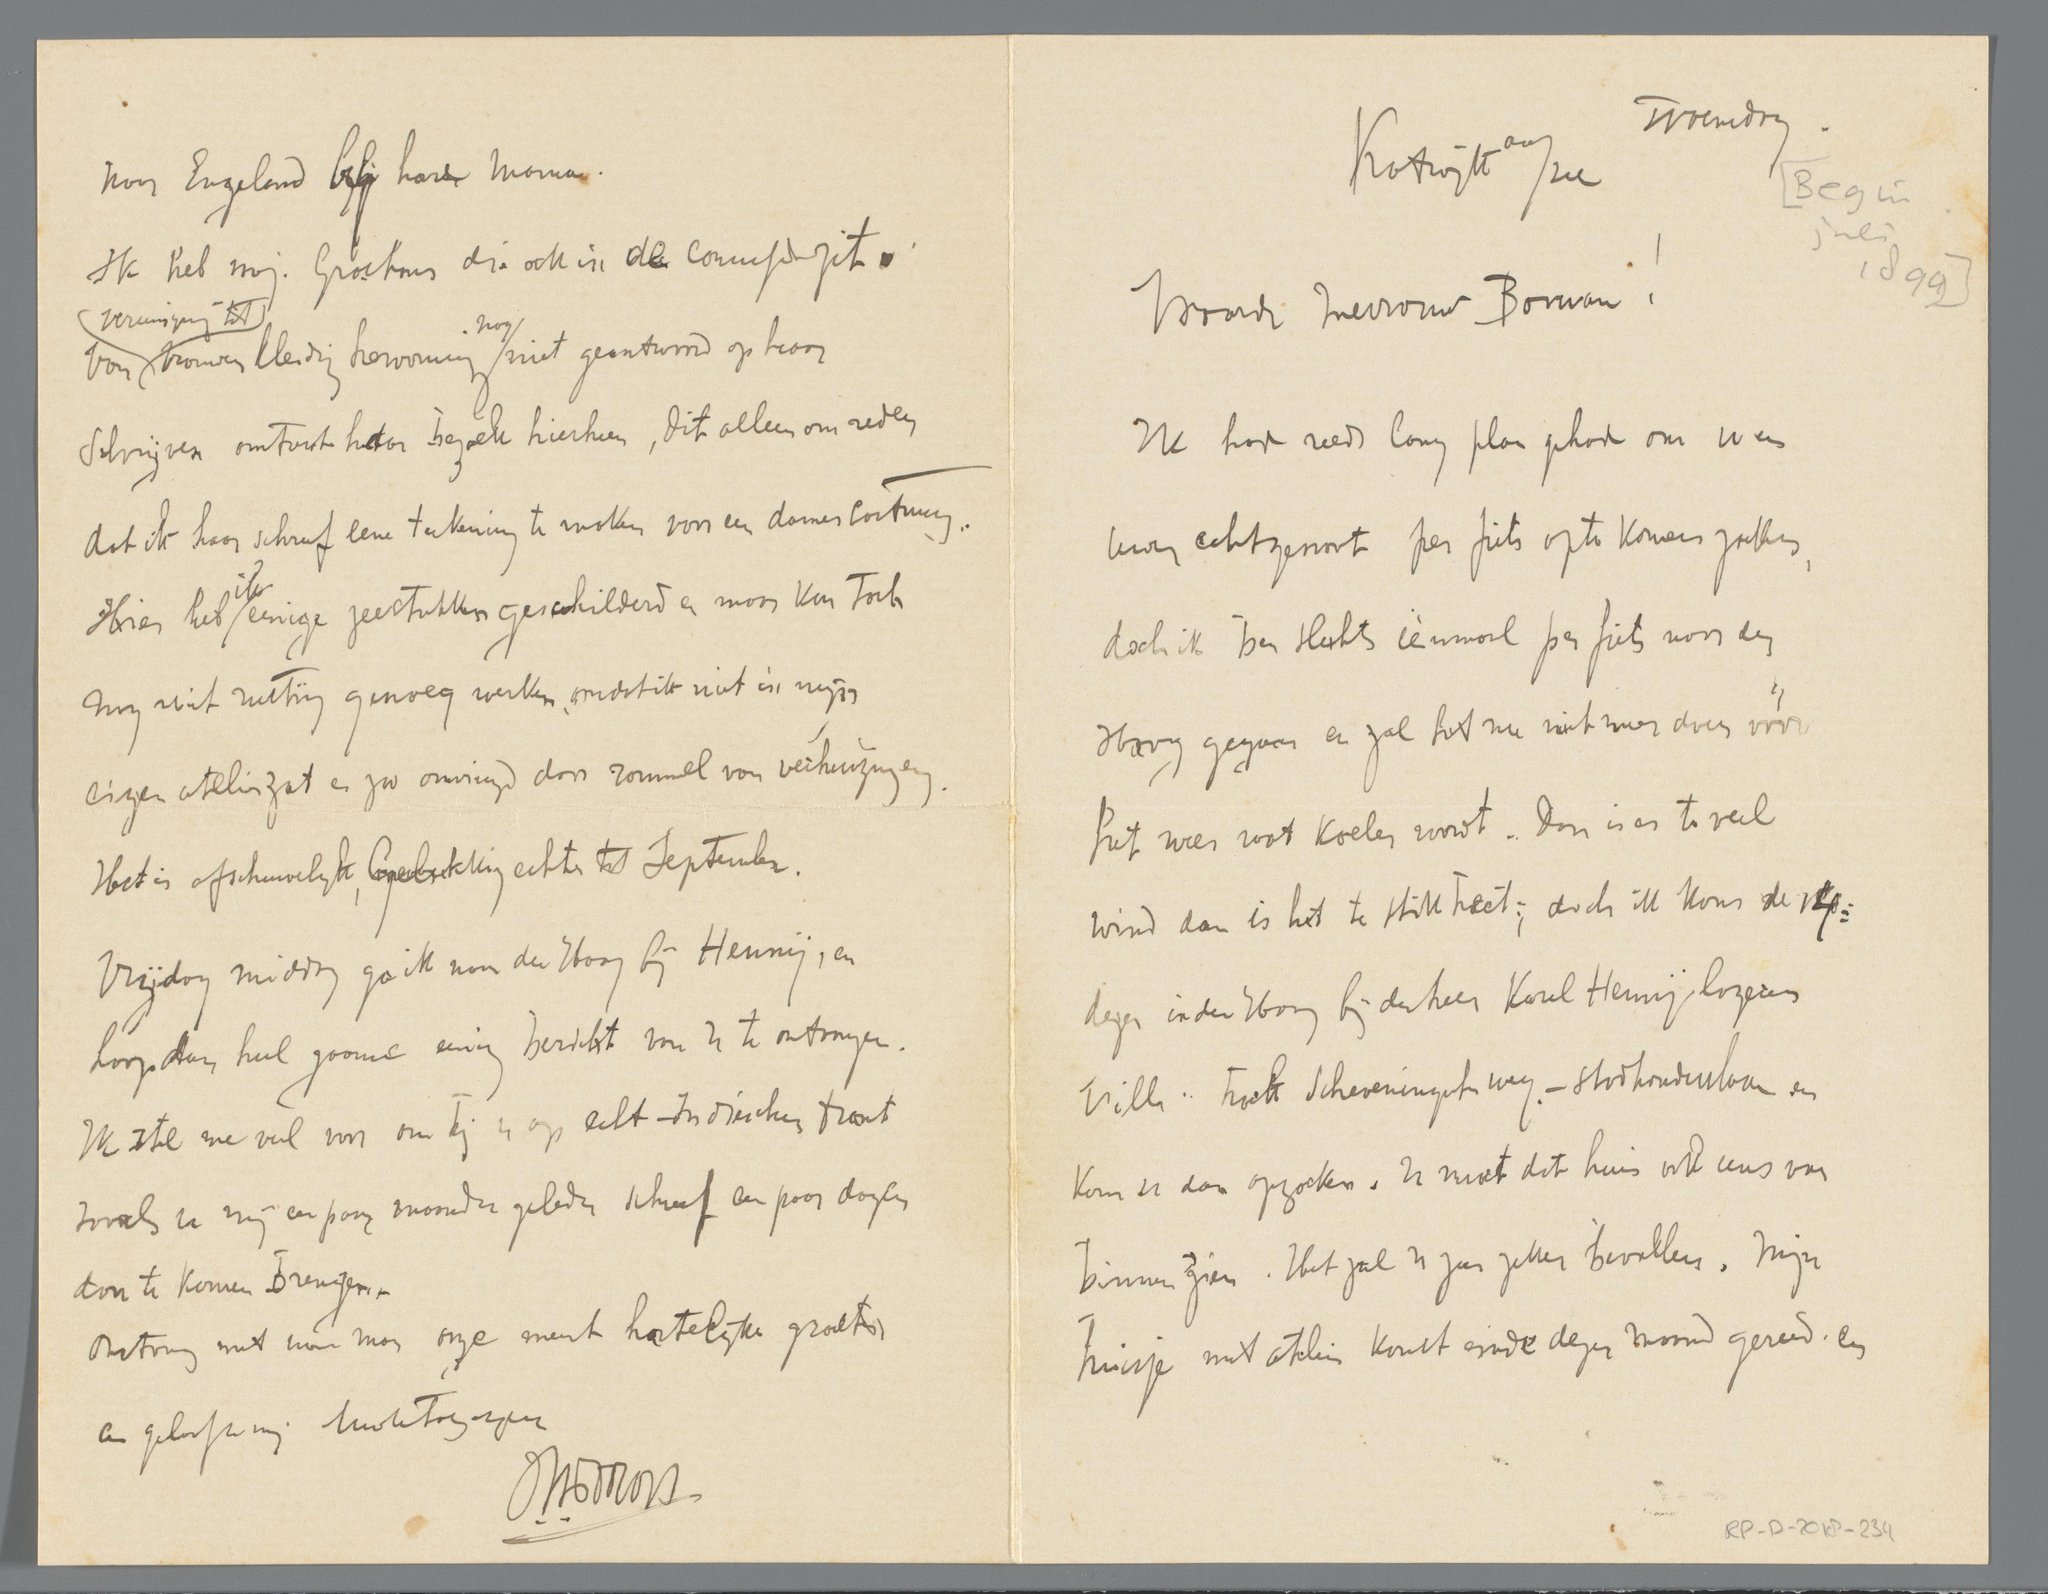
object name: letter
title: Brief aan Jeannette Bouman-Stuyling de Lange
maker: jan toorop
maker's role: draughtsman, painter, print maker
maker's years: 1858-1928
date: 1900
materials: ink, paper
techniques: pen, writing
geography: katwijk aan zee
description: Briefkaart gericht aan Mevrouw J. Bouman, Geb Stuylingh de Lange, Villa Val di Rena, Scheveningen.